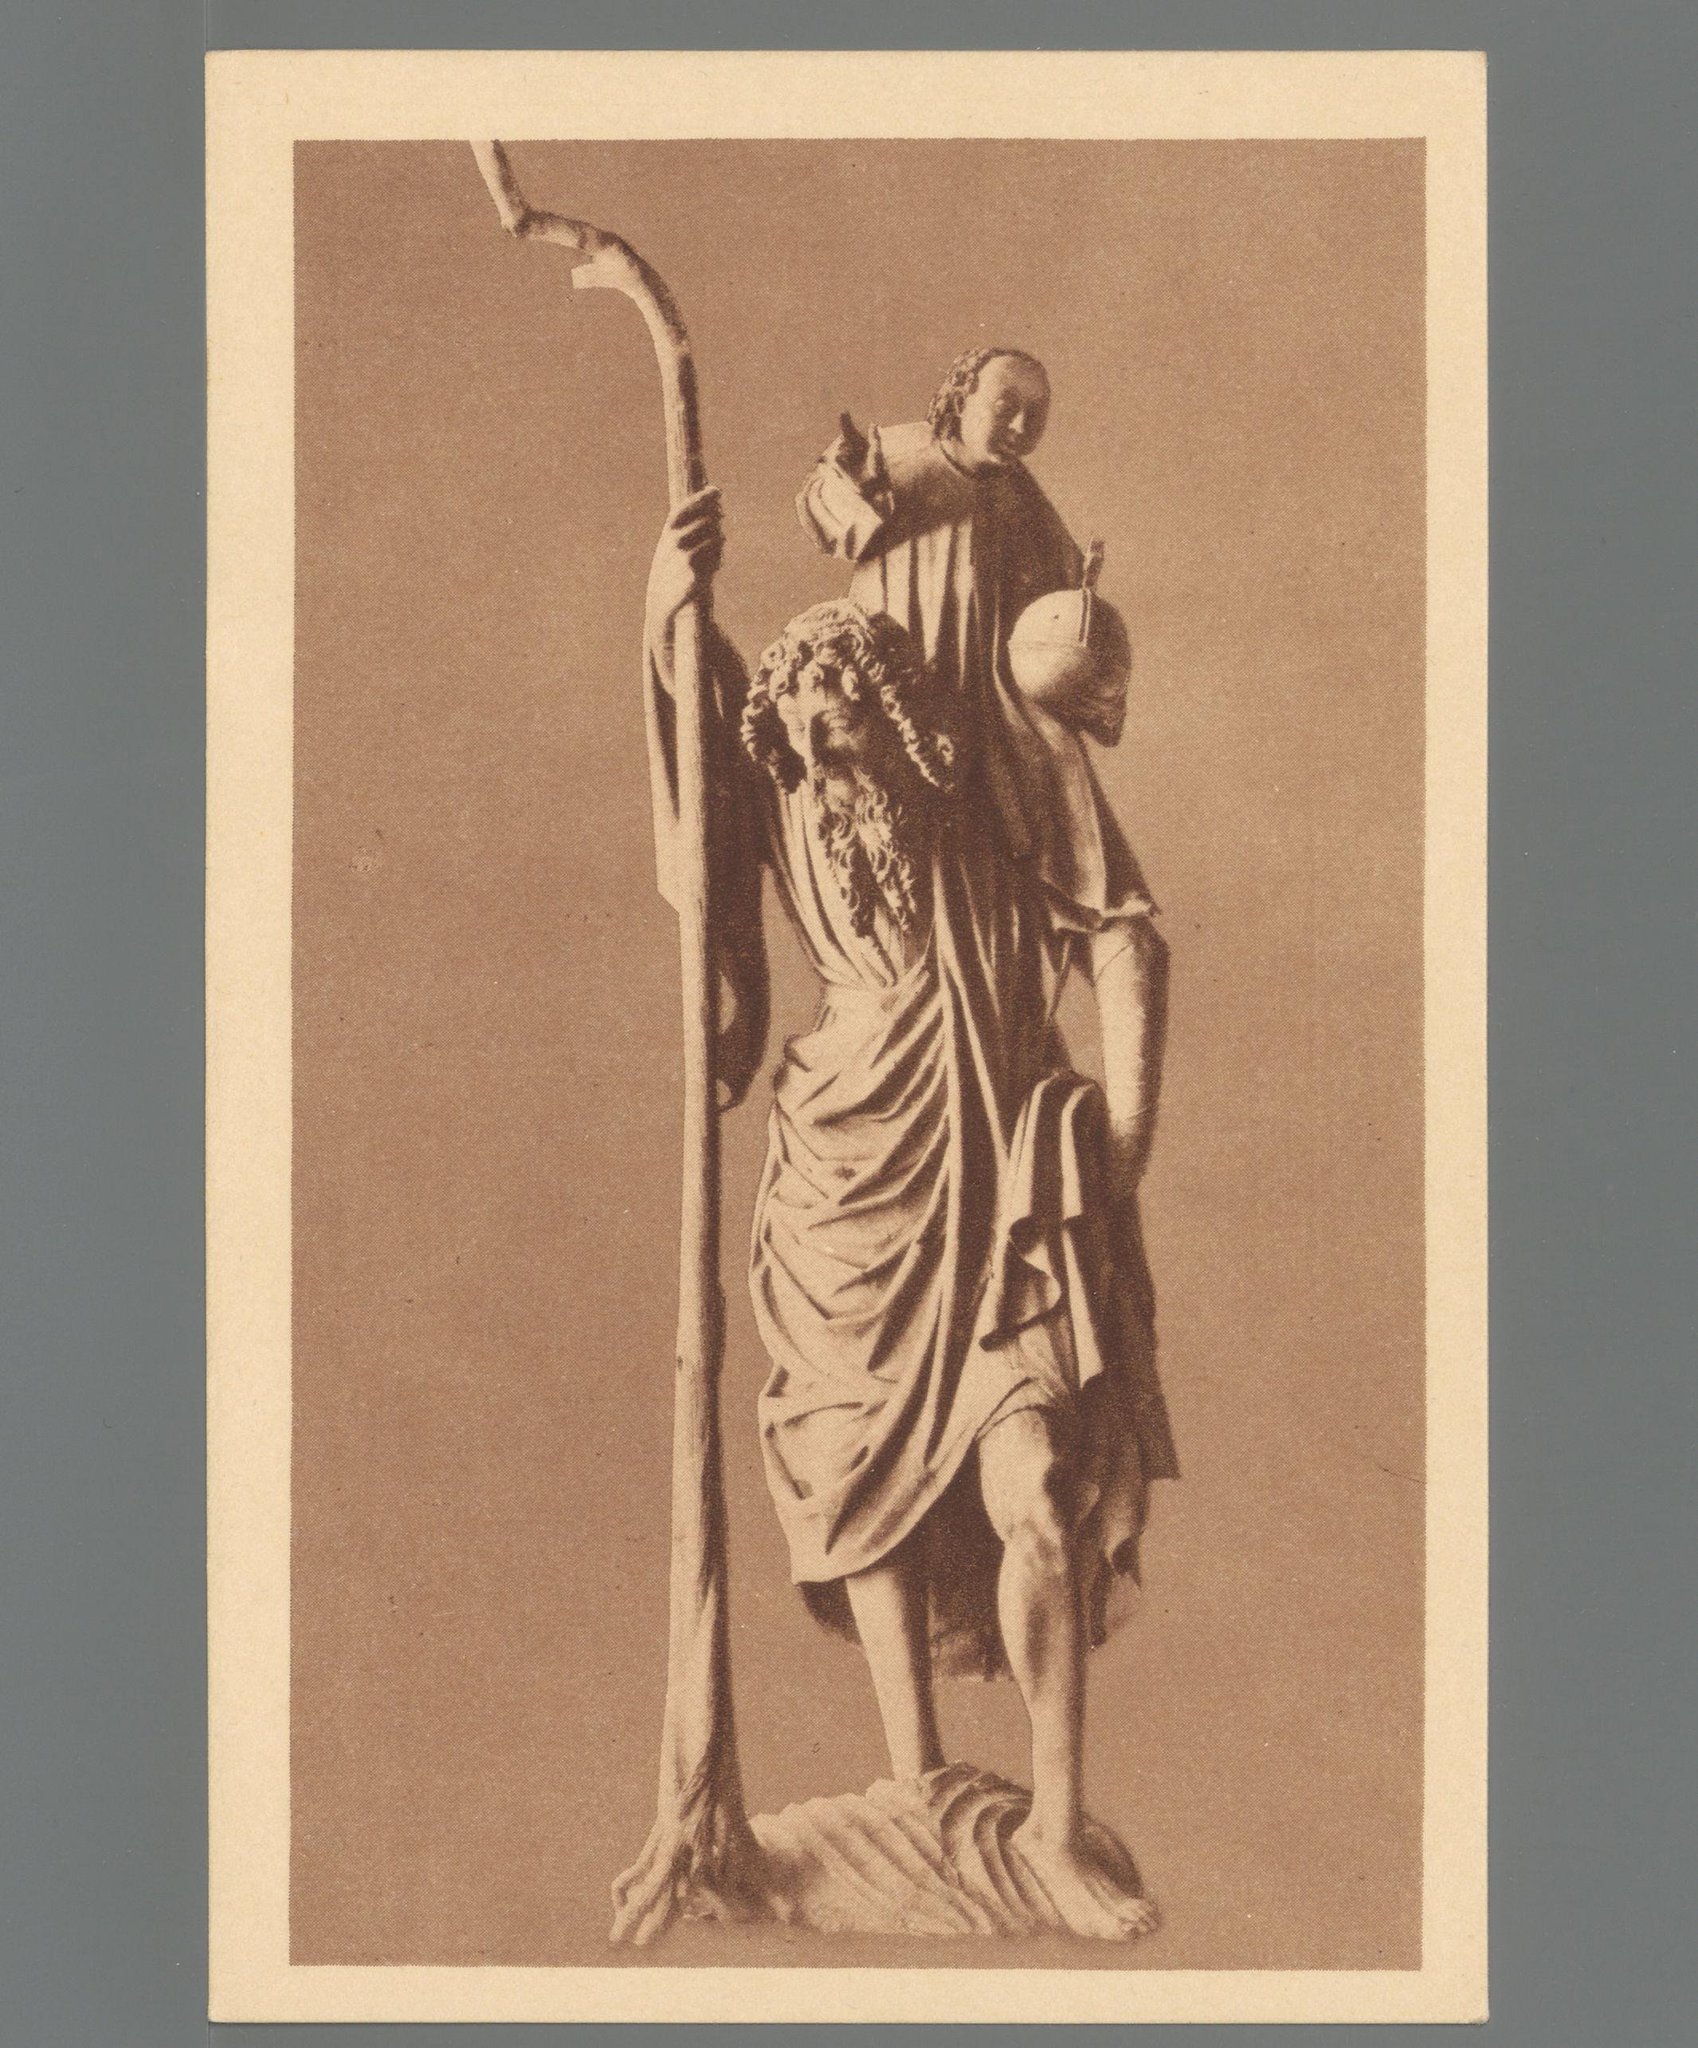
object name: photomechanical print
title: Nederrijnsche School, omstreeks 1500. St. Christoffel met het Christuskind, eikenhout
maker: Anonymous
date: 1921-1940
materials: cardboard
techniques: rotogravure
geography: utrecht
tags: sculpture, the giant and martyr christophorus; possible attributes: palm-tree (with bunches of dates, or withered), infant christ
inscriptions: collector's mark: ‘AFE v S’